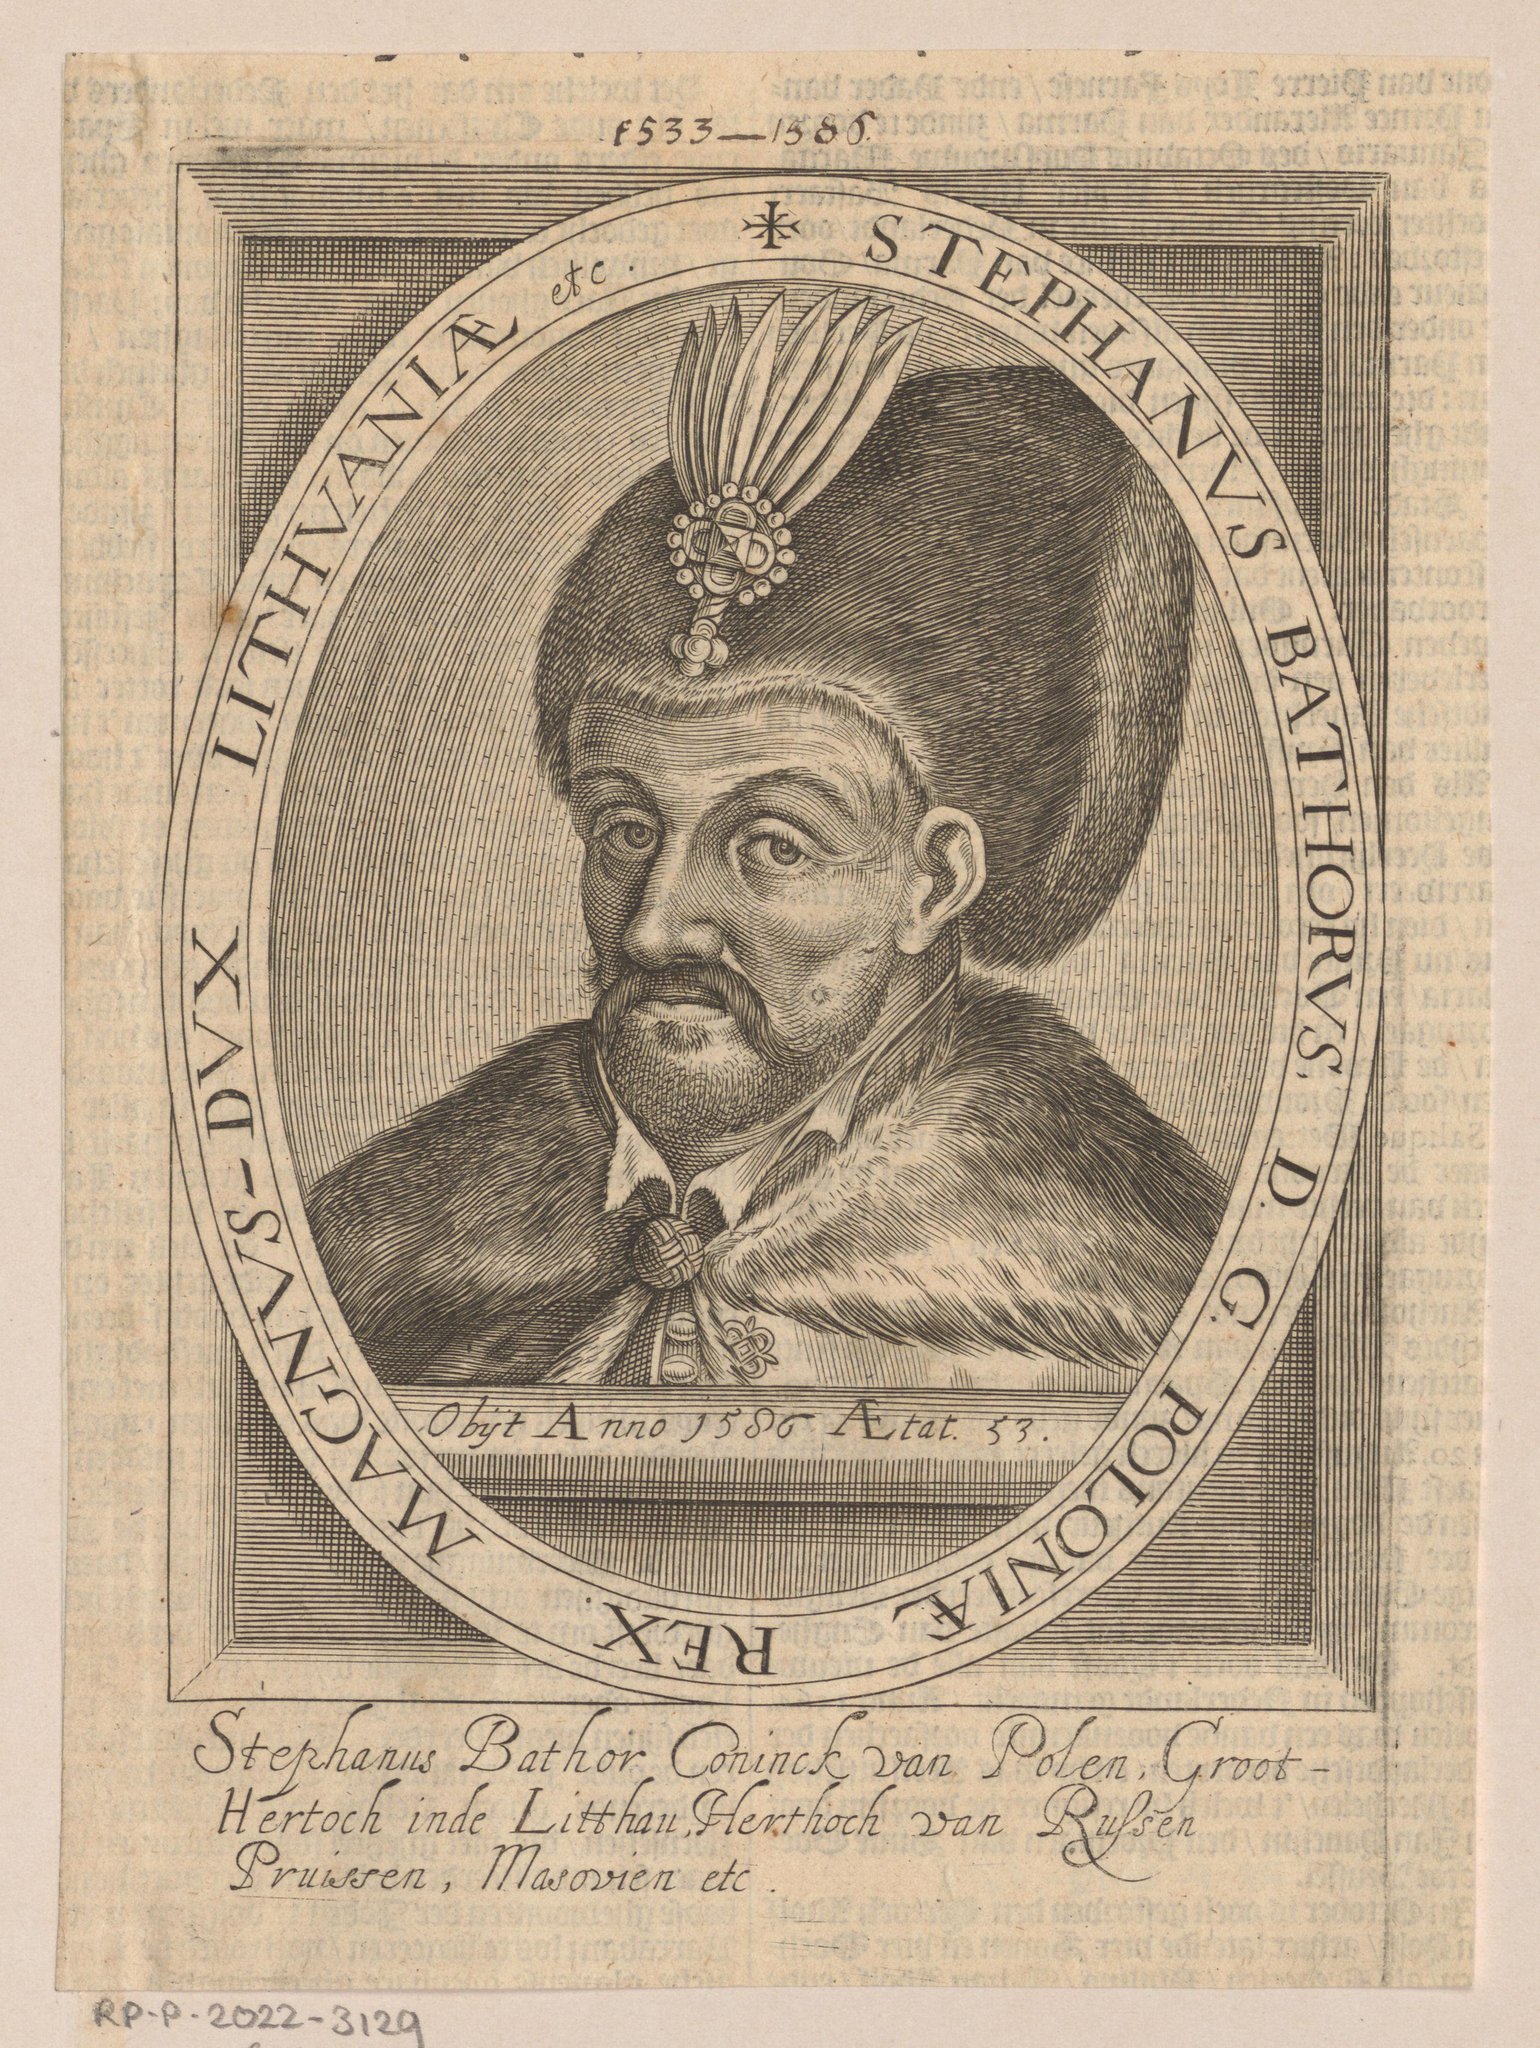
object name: print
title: Portret van Stefanus Báthory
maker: Anonymous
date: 1623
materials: paper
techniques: engraving, letterpress printing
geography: the hague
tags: historical persons, king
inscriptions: number: ‘1533-1585’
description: Prent uit: Meteren, Emanuel van. Historie der Nederlandscher ende haerder na-buren oorlogen ende geschiedenissen (...). Den Haag: weduwe en erven Hillebrant Iacobsz. van Wouw, 1623.